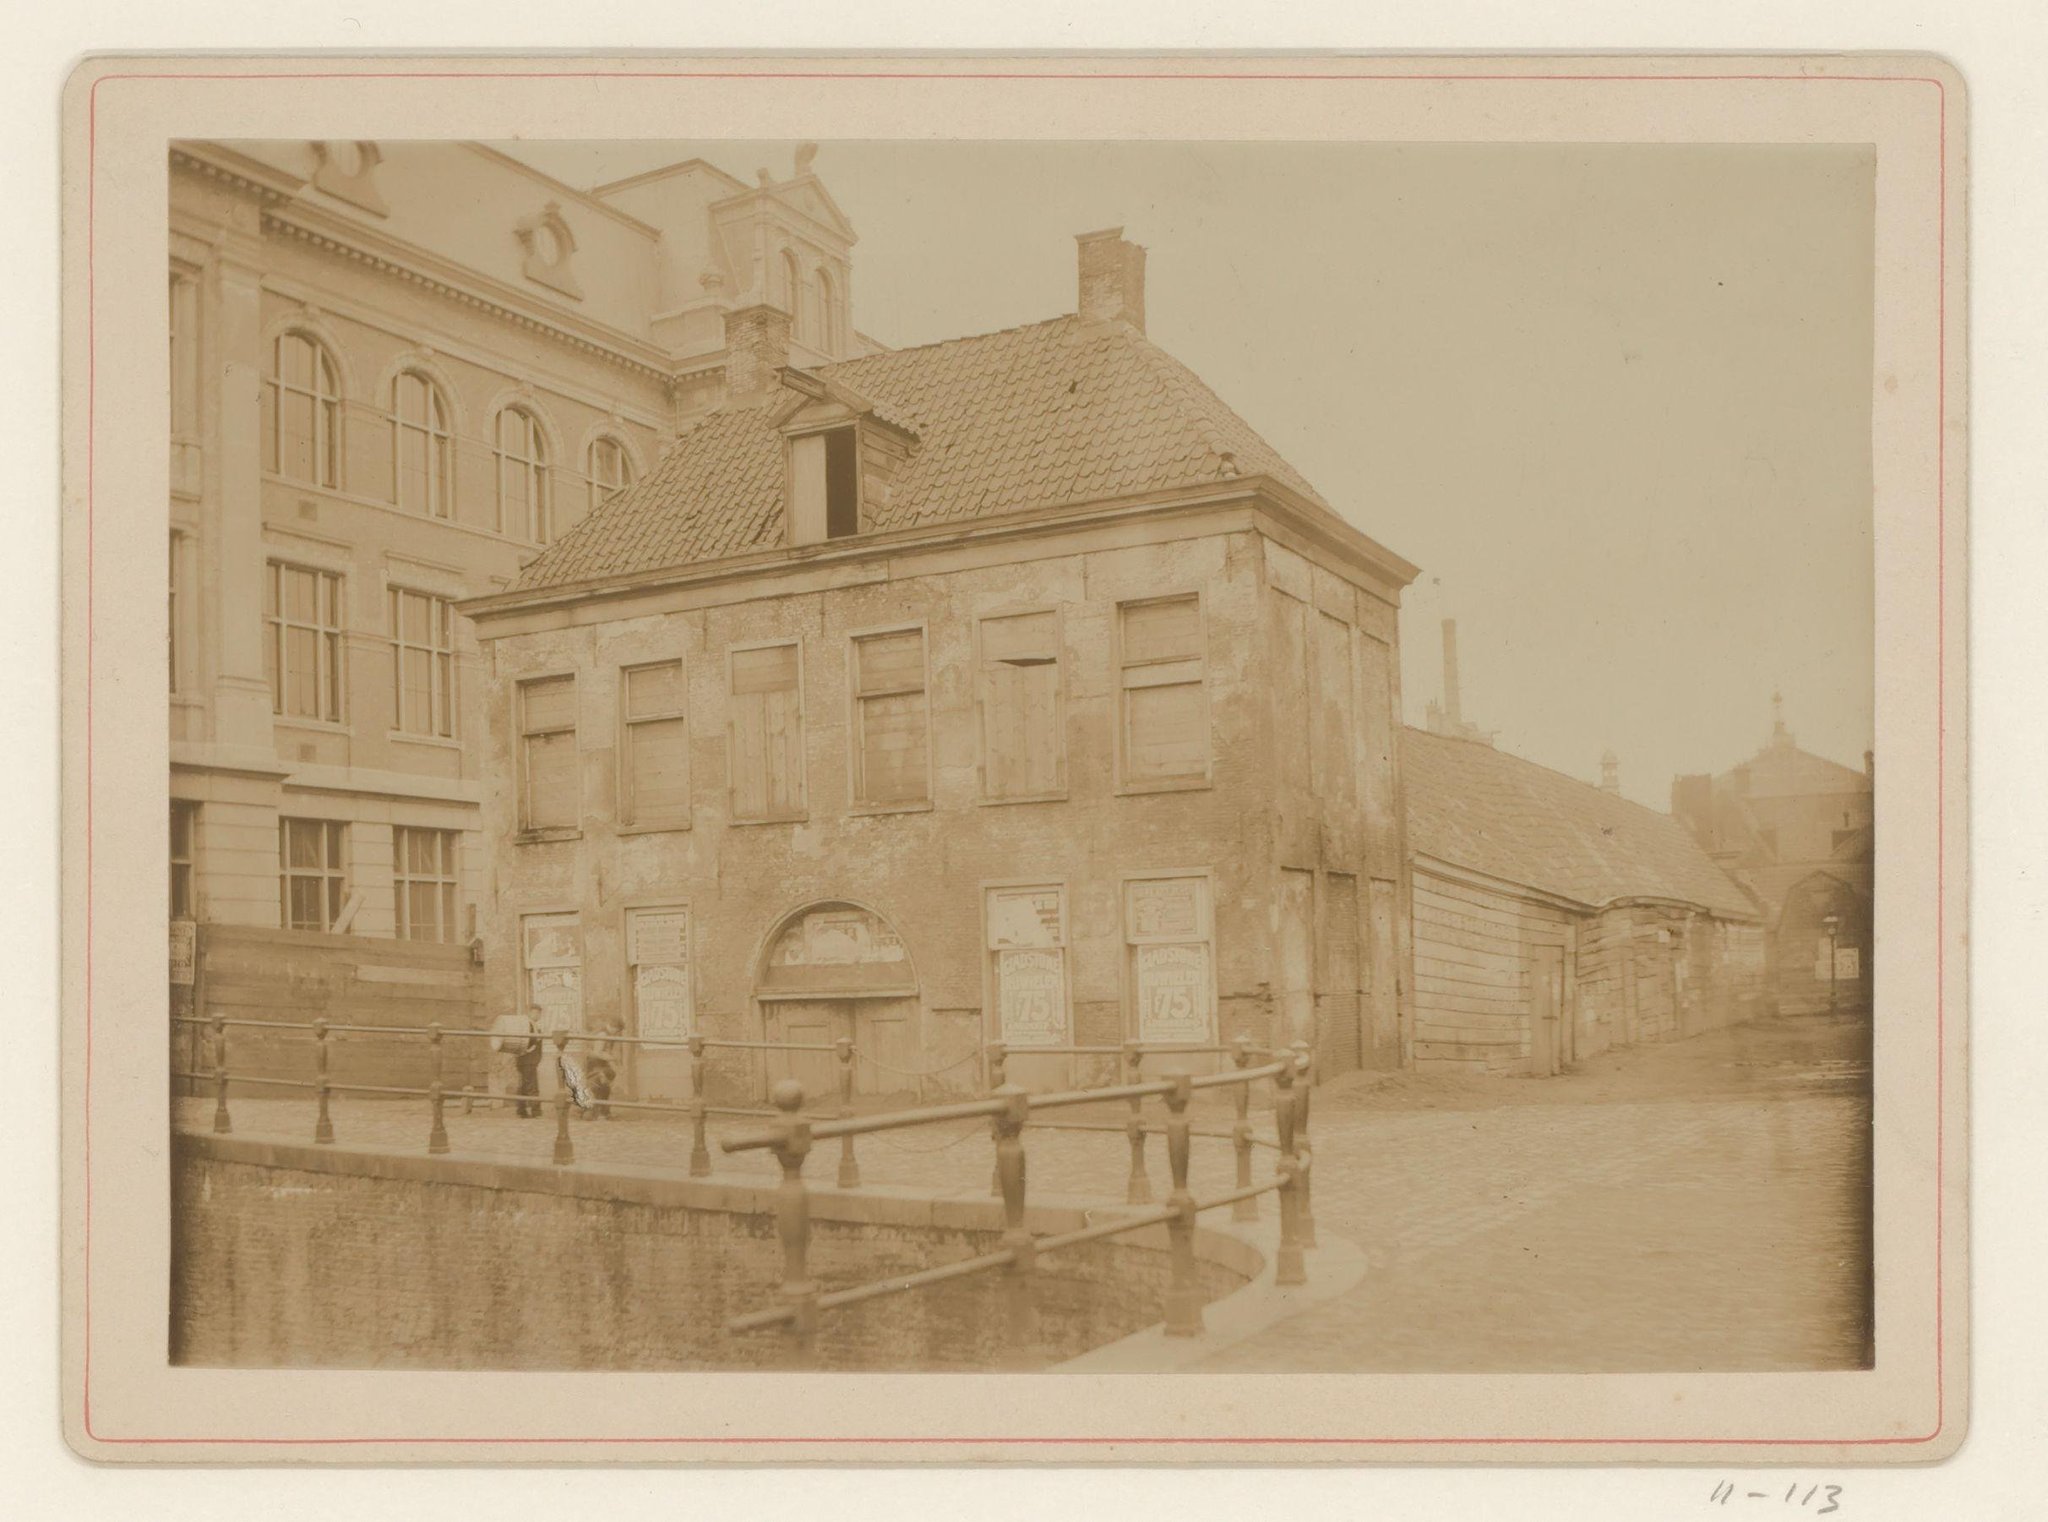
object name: cabinet photograph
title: Gezicht op een oude schuur op het Raamplein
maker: Anonymous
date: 1882-1930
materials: paper, cardboard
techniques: gelatin silver print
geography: amsterdam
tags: city-view in general; 'veduta', façade (of house or building), street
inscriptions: collector's mark: ‘11.113’ Lugt 1641b, inscription: ‘Oude schuur, thans (...) b/d Leidschegracht. / Raamplein’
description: Onderwerpsrubriek binnen de Atlas Amsterdam: Raadhuisstraat, Raamgracht, Raamplein, Rapenburgerstraat, Reguliersgracht, Reguliersbreestraat.